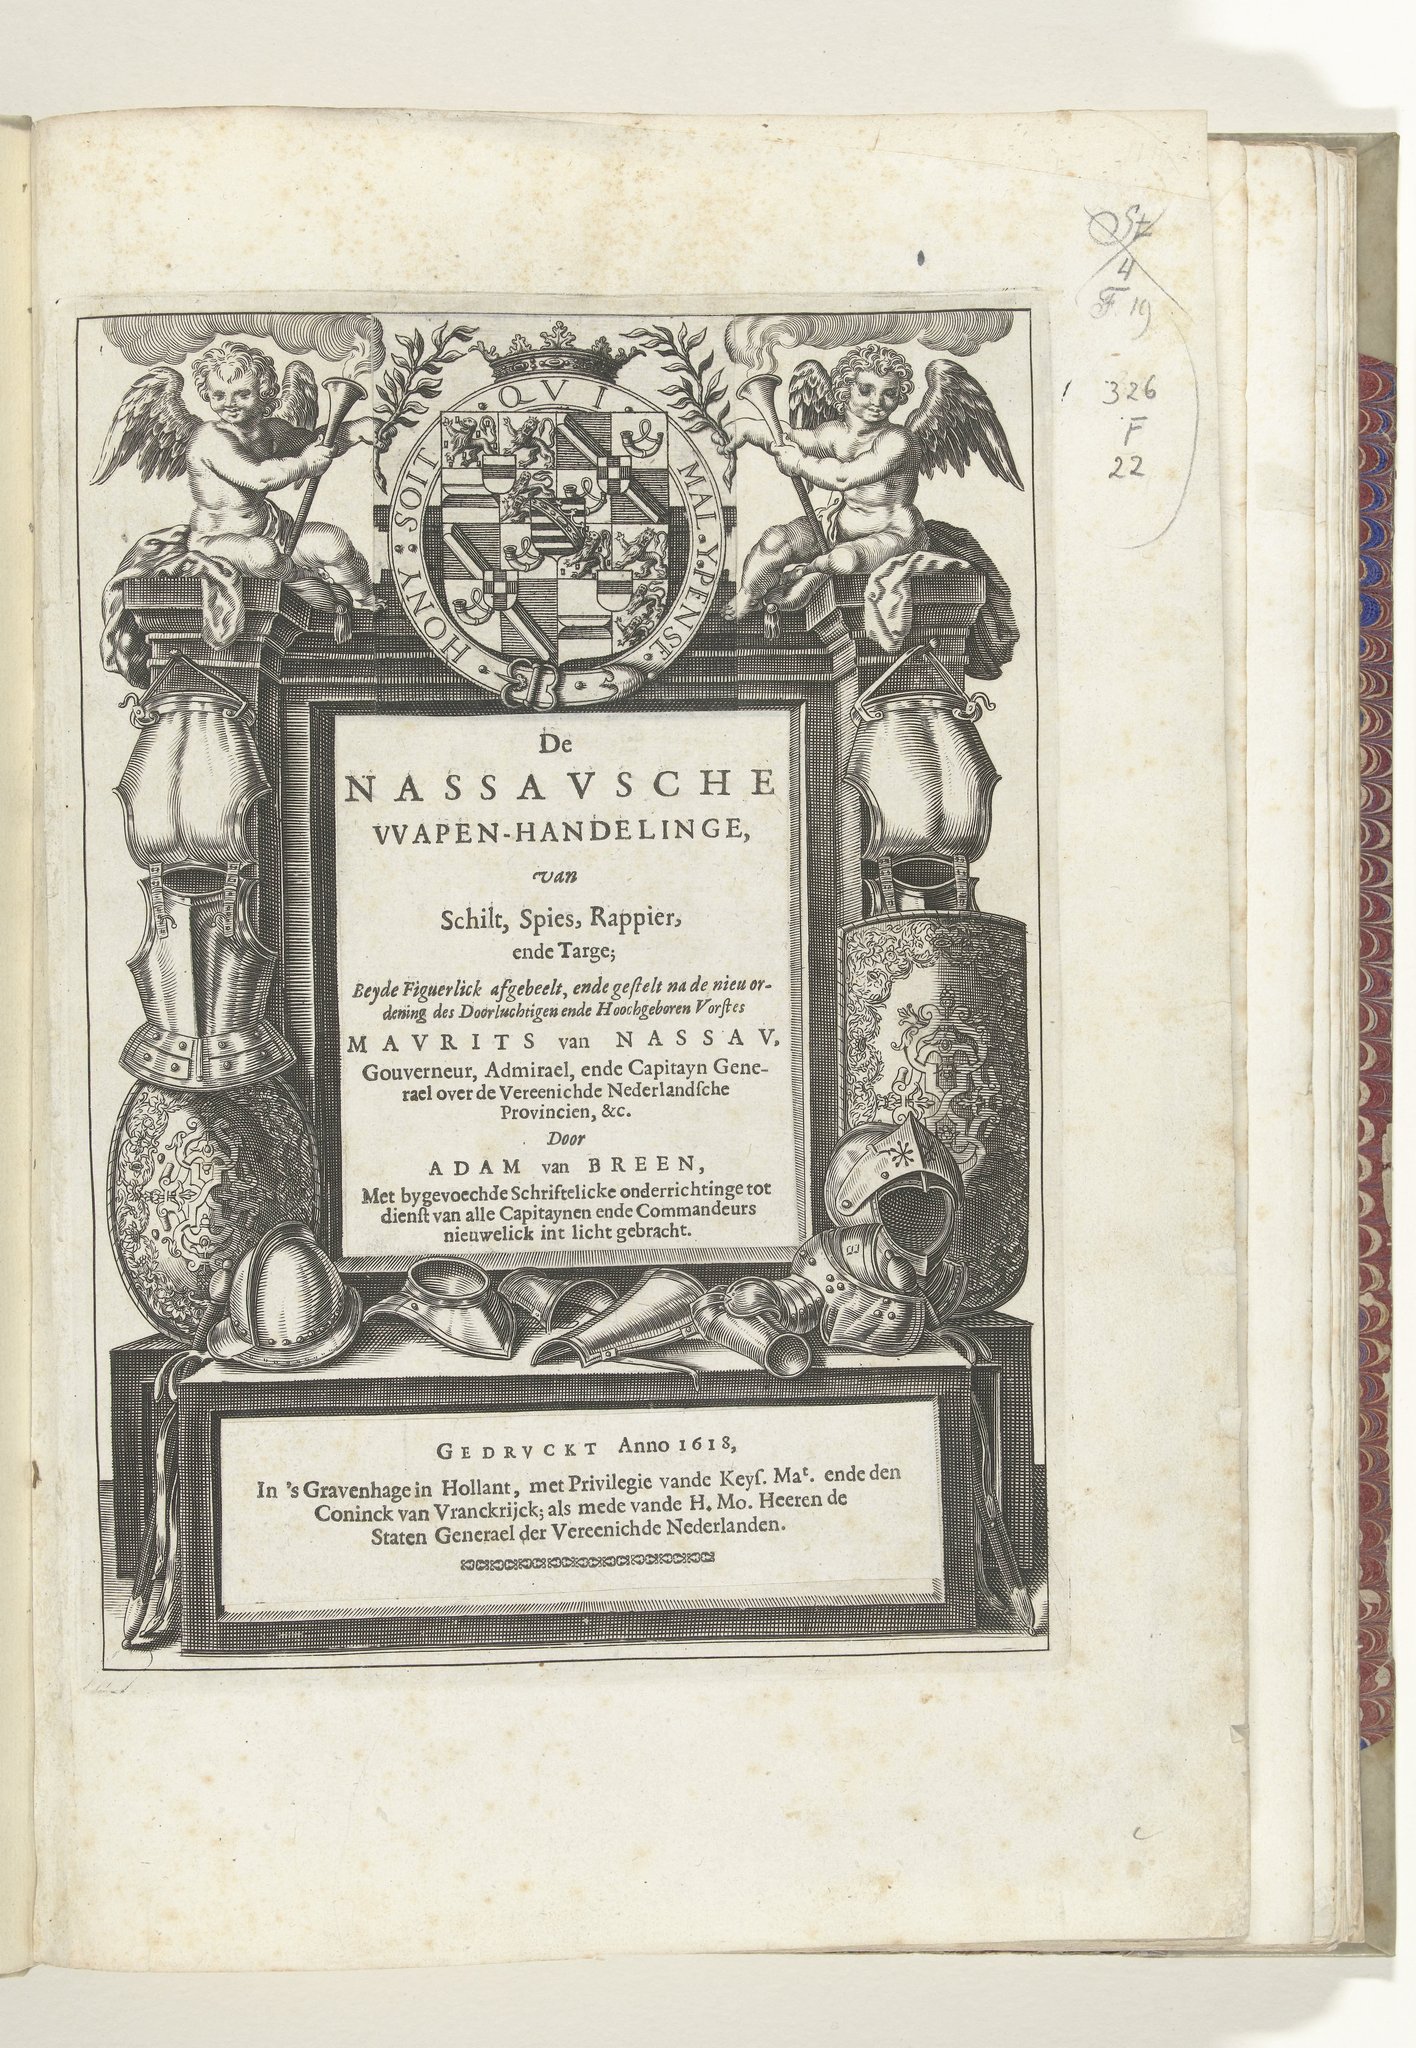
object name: titelblad, titelpagina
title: Titelpagina van Adam van Breens De Nassausche Wapen-Handelinge, 1618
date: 1616-1618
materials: paper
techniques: engraving, letterpress printing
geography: northern netherlands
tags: the hague, maurice (prince of orange), armour, title-page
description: Illustratie in: Adam van Breen, De Nassausche Wapen-Handelinge, van Schilt, Spies, Rappier ende Targe : beyde figuerlick afgebeelt, ende gestelt na de nieu ordening [van] ... Maurits van Nassau, 's-Gravenhage, [Aert Meuris] 1618, titelpagina. In het exemplaar in de collectie van de Rijksmuseum Research Library (326 F 22).